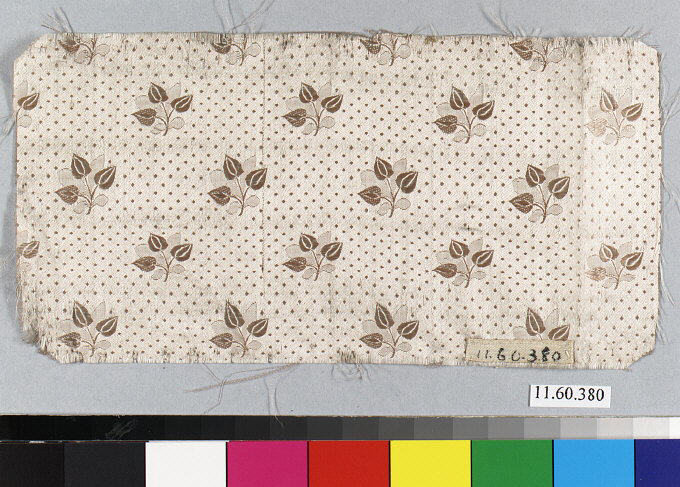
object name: fragment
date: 1801-1900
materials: silk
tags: leaves